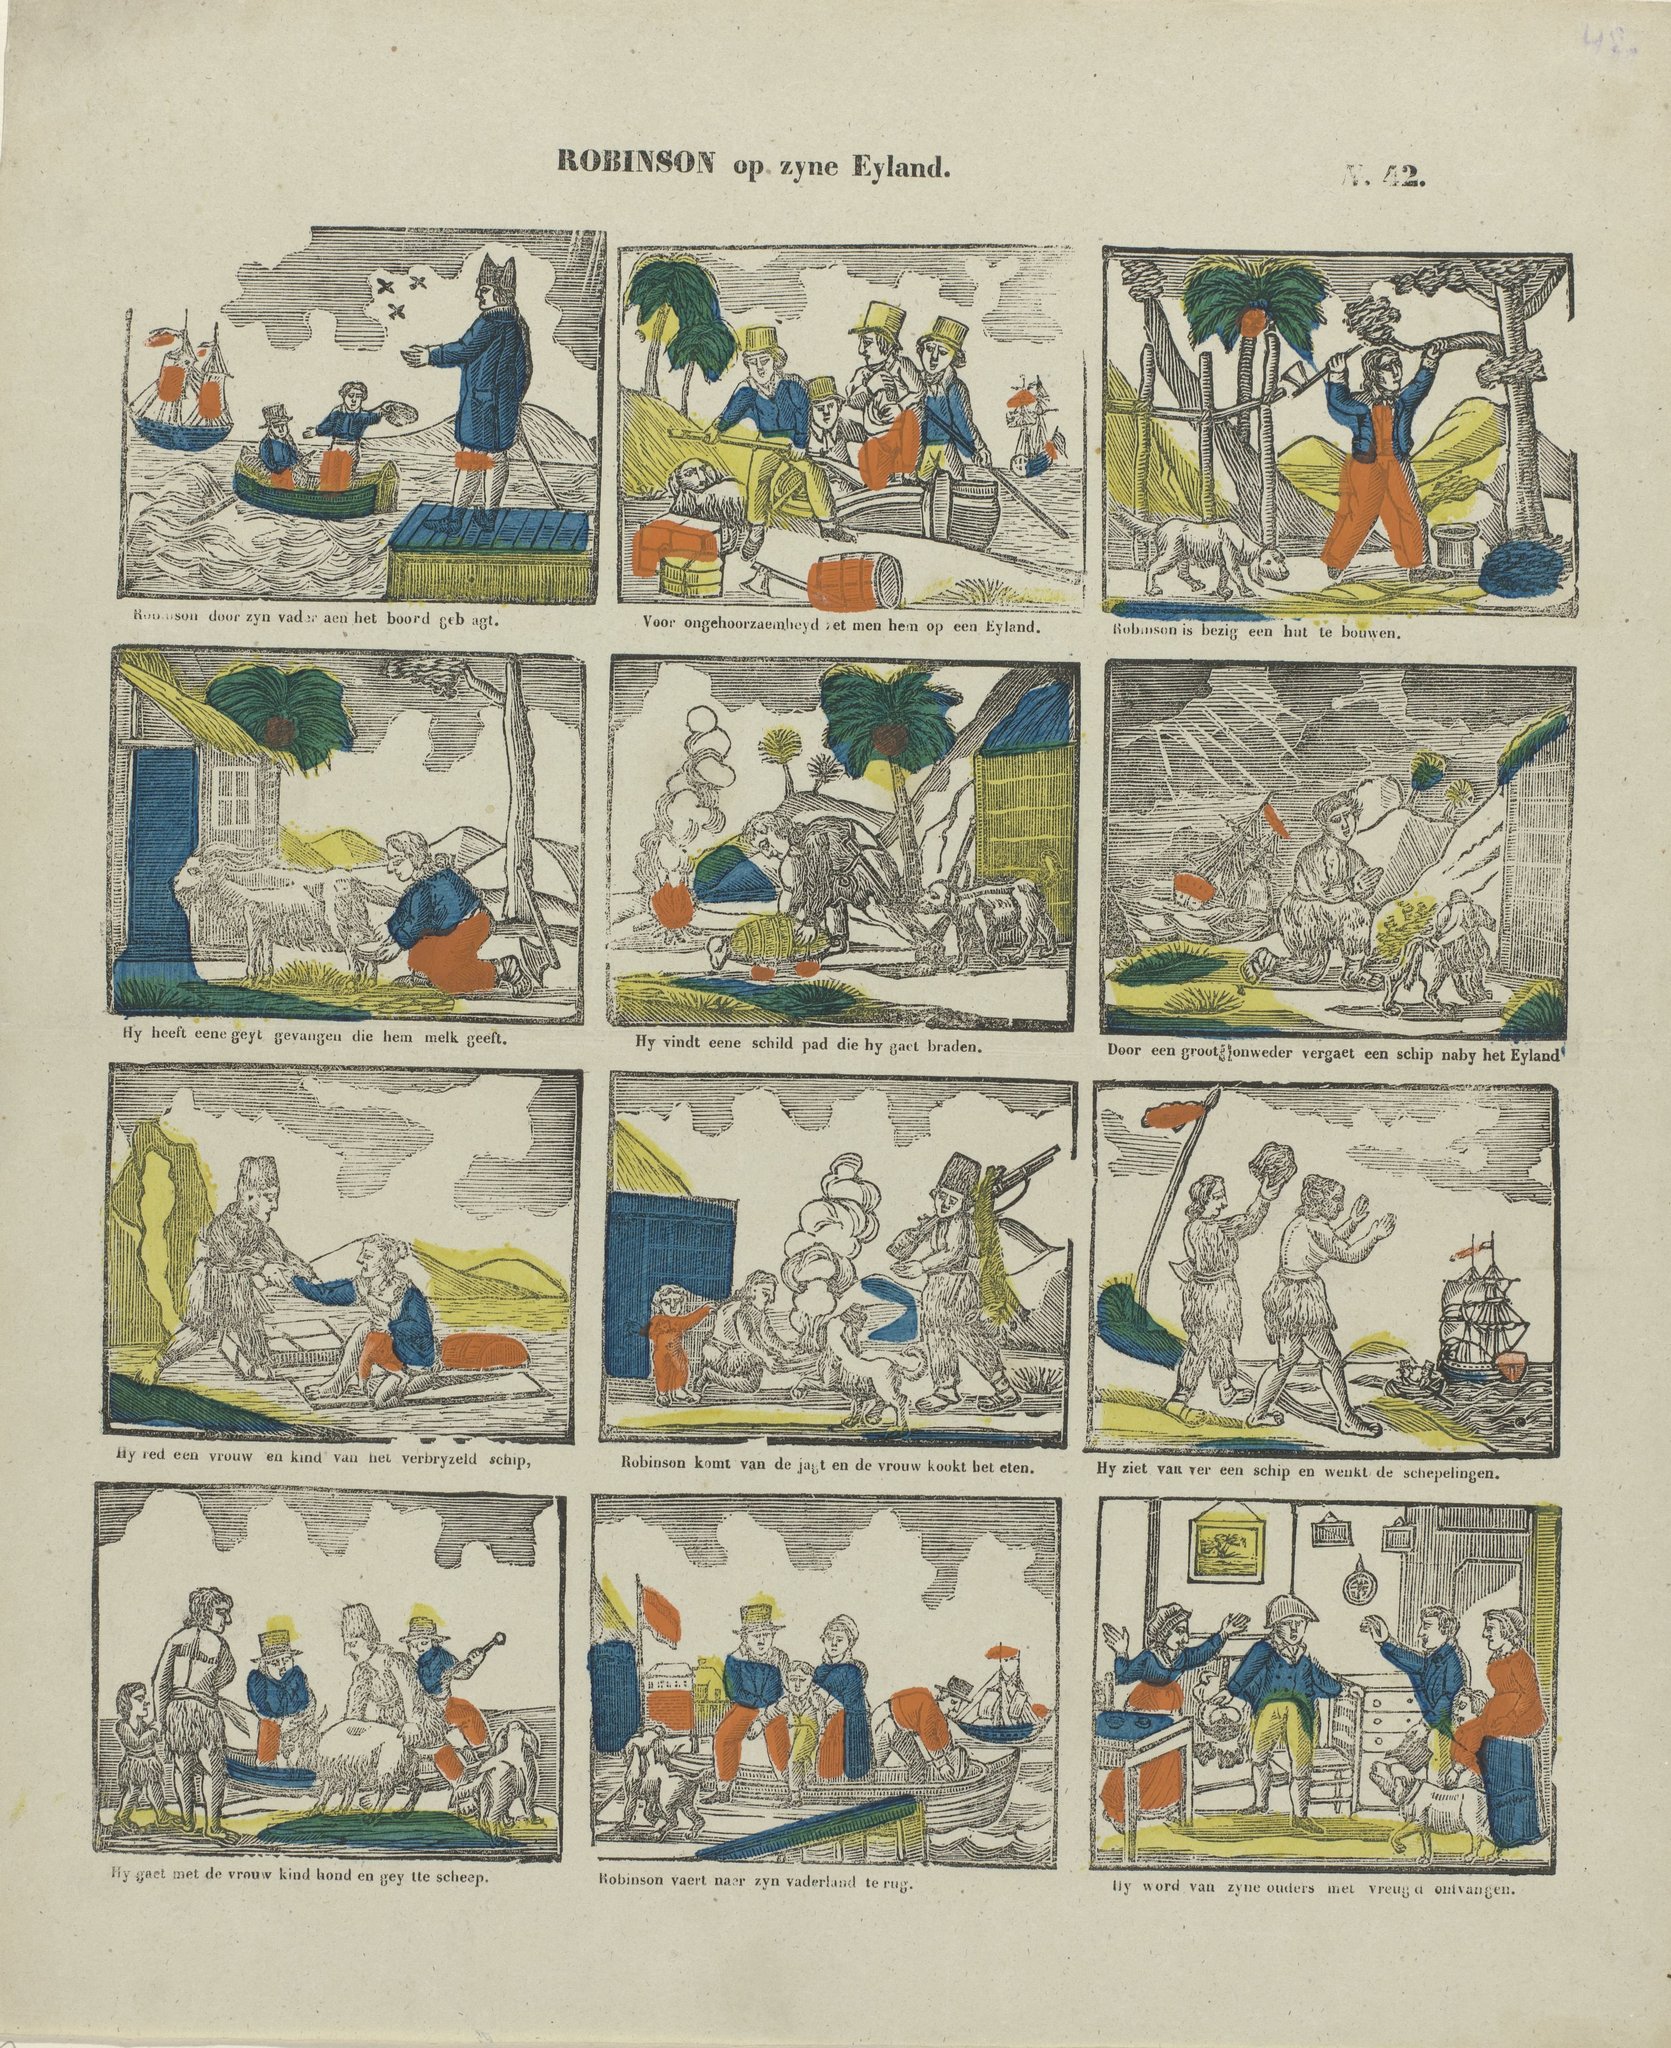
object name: popular print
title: Robinson op zyne eyland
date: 1842-1856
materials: paper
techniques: colour, letterpress printing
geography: turnhout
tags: (scenes from) specific works of literature: defoe, robinson crusoe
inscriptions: collector's mark: Lugt 2760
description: Blad met 12 voorstellingen uit het verhaal van Robinson Crusoe die strandt op een eiland. Onder elke voorstelling een versregel. Genummerd rechtsboven: N. 42.